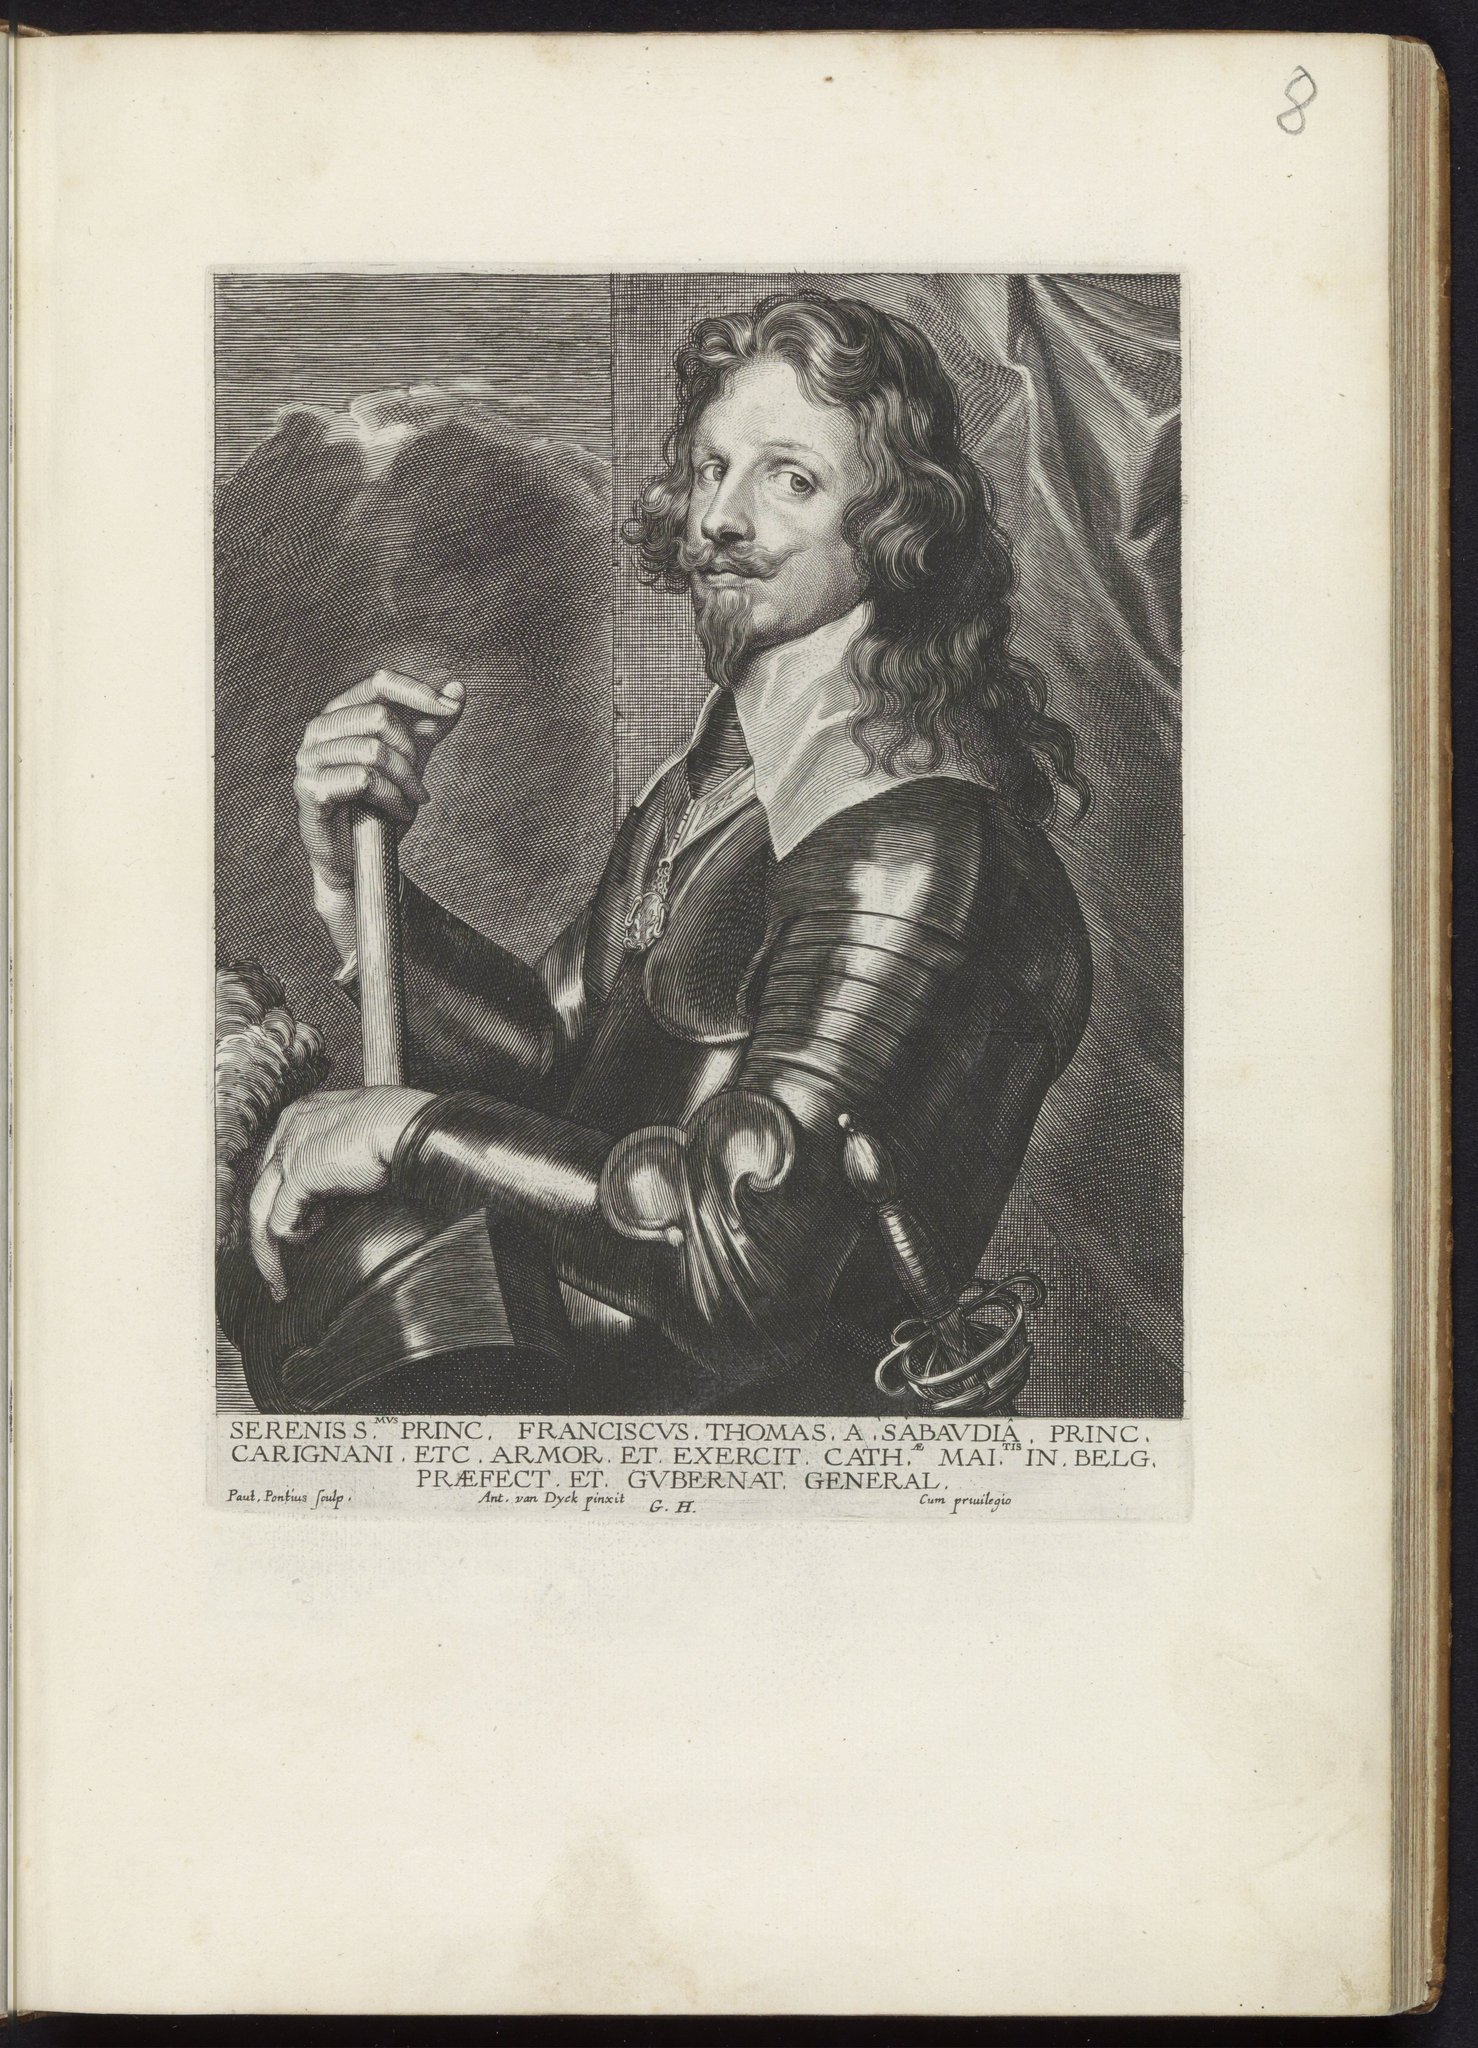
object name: print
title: Icones Principum Vivorum Doctorum Pictorum Chalcographorum Statuariorum nec non Amatorum Pictoriae Artis Numero Centum ab Antonio van Dyck Pictore ad Vivum Expressae Eiusq: Sumptibus aeri incisae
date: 1630-1641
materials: paper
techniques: engraving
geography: antwerp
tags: knighthood order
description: Portret van Tommaso Francesco, prins van Savoye-Carignano. Hij draagt een keten met de Hoogste Orde van de Verkondiging. Deze prent maakt deel uit van een album.